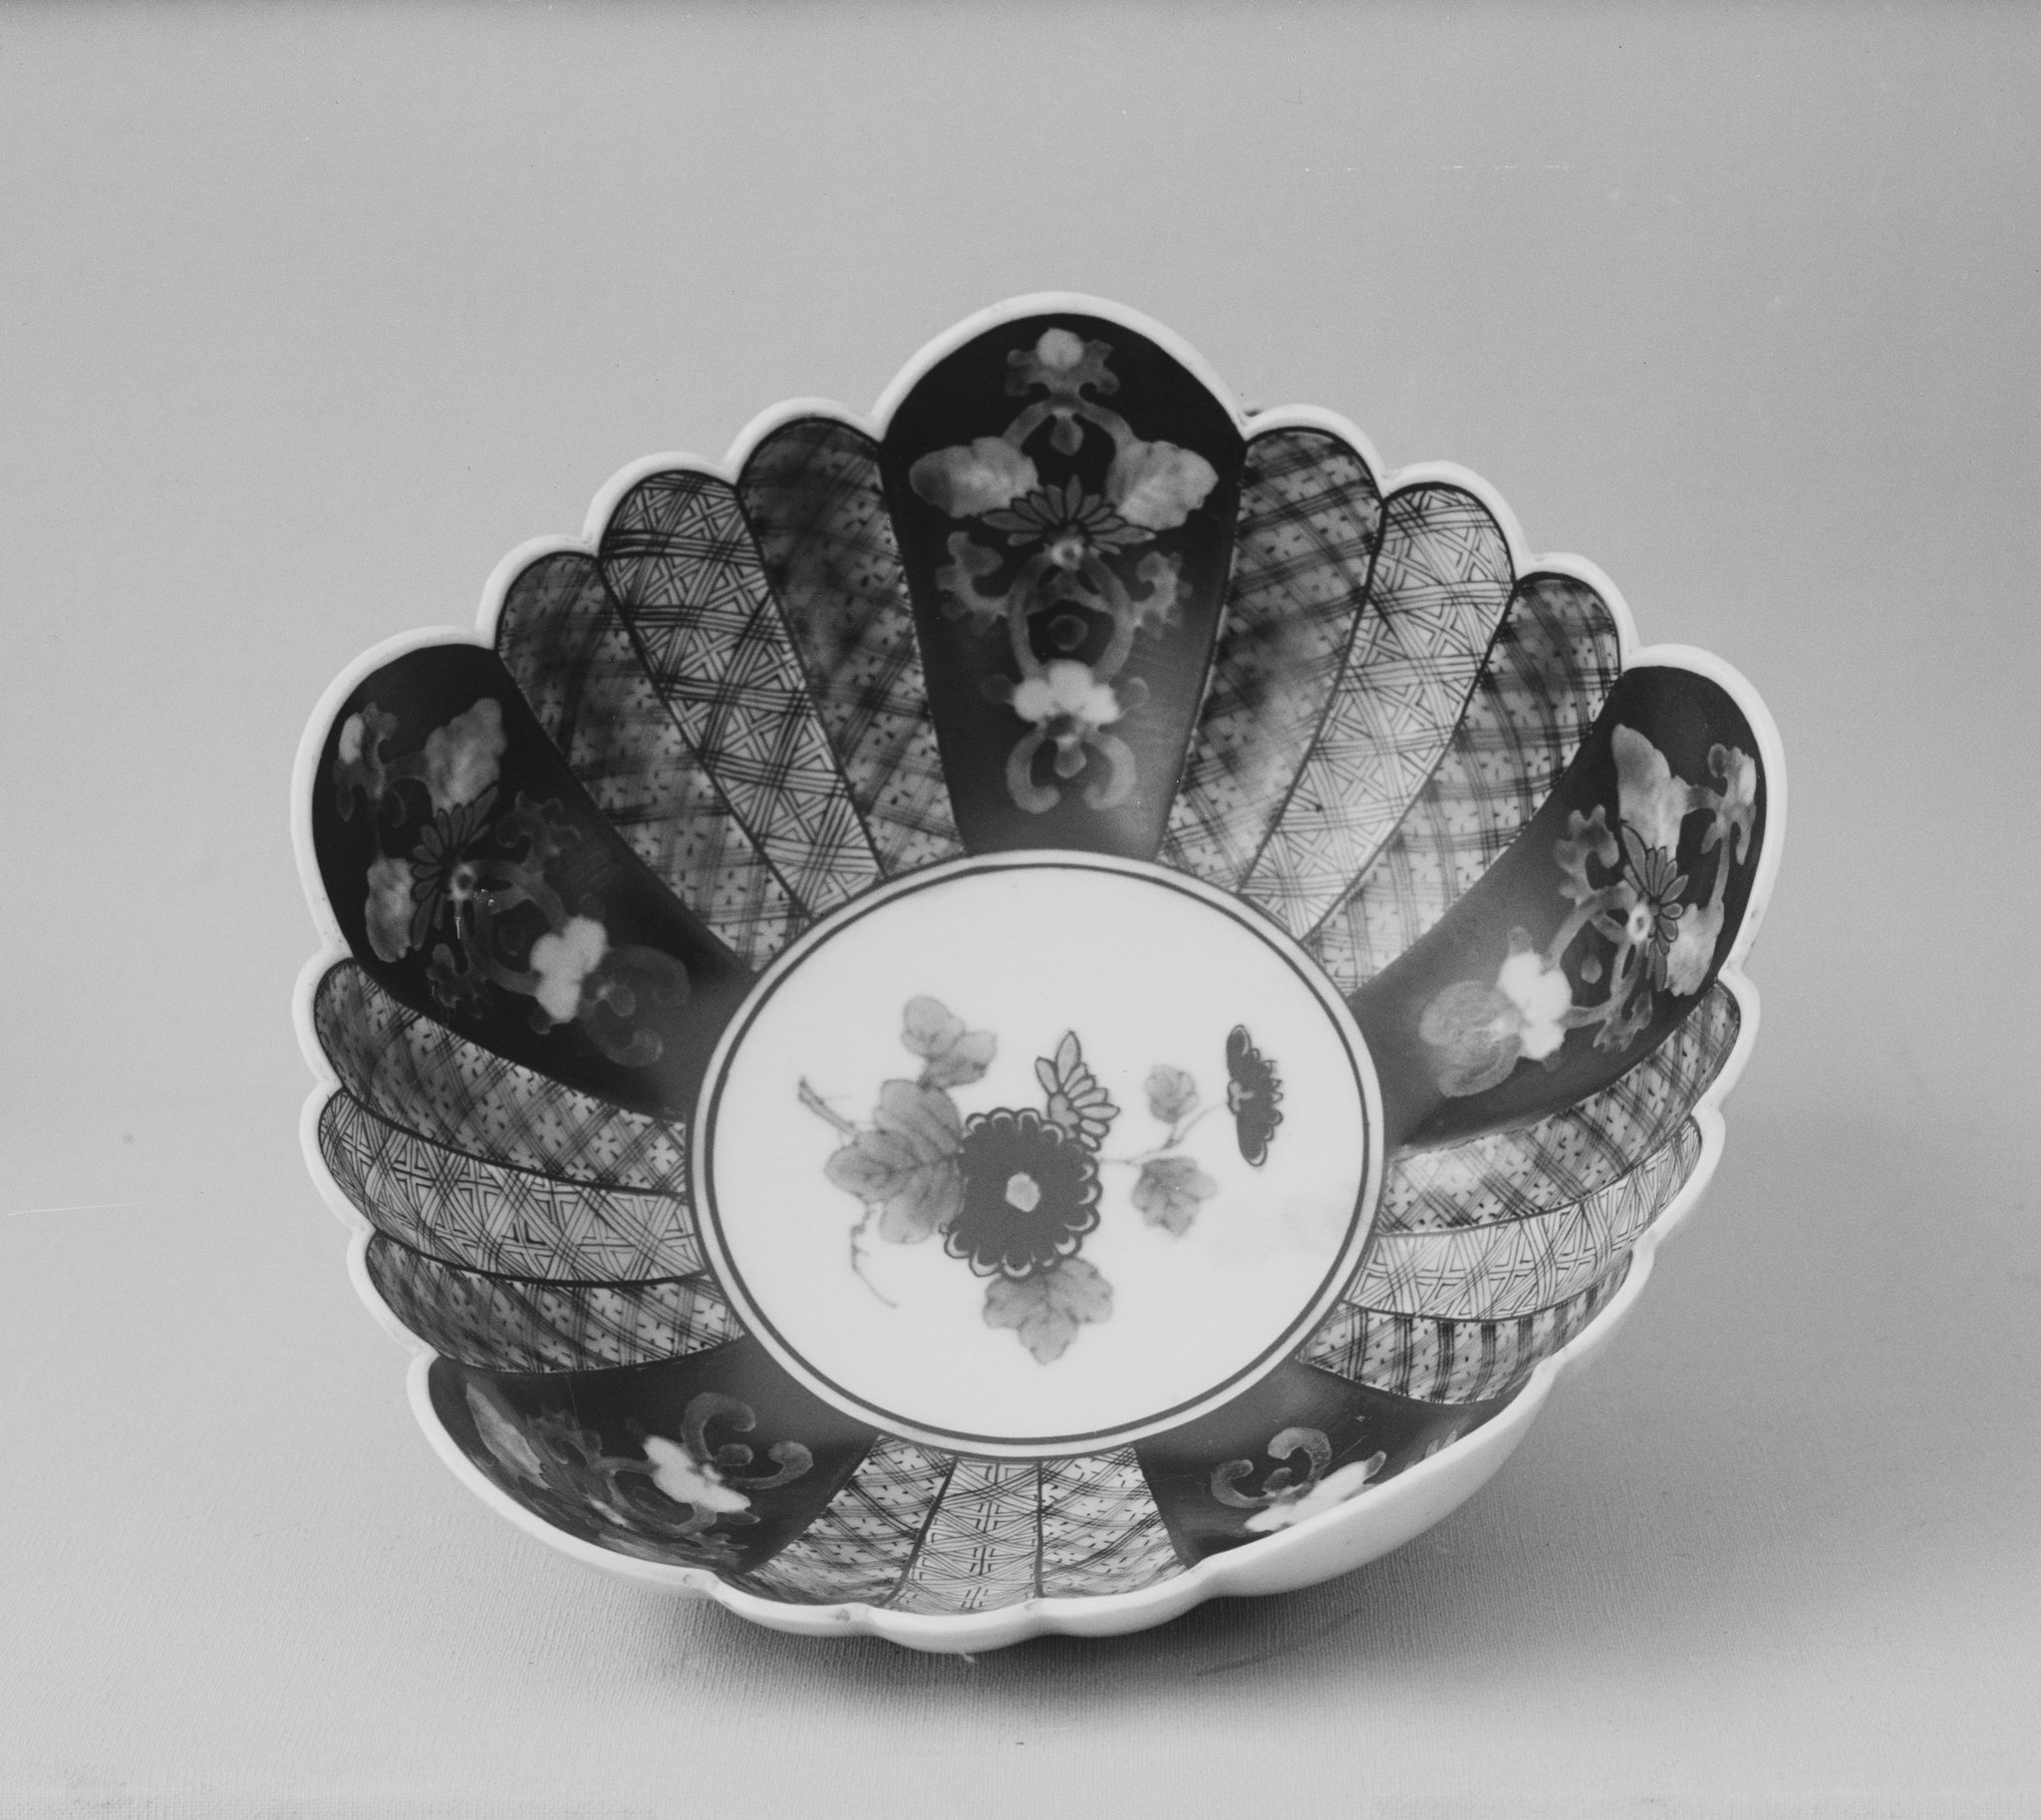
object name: bowl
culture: japanese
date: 1780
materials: glaze, gold, iron, porcelain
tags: flowers